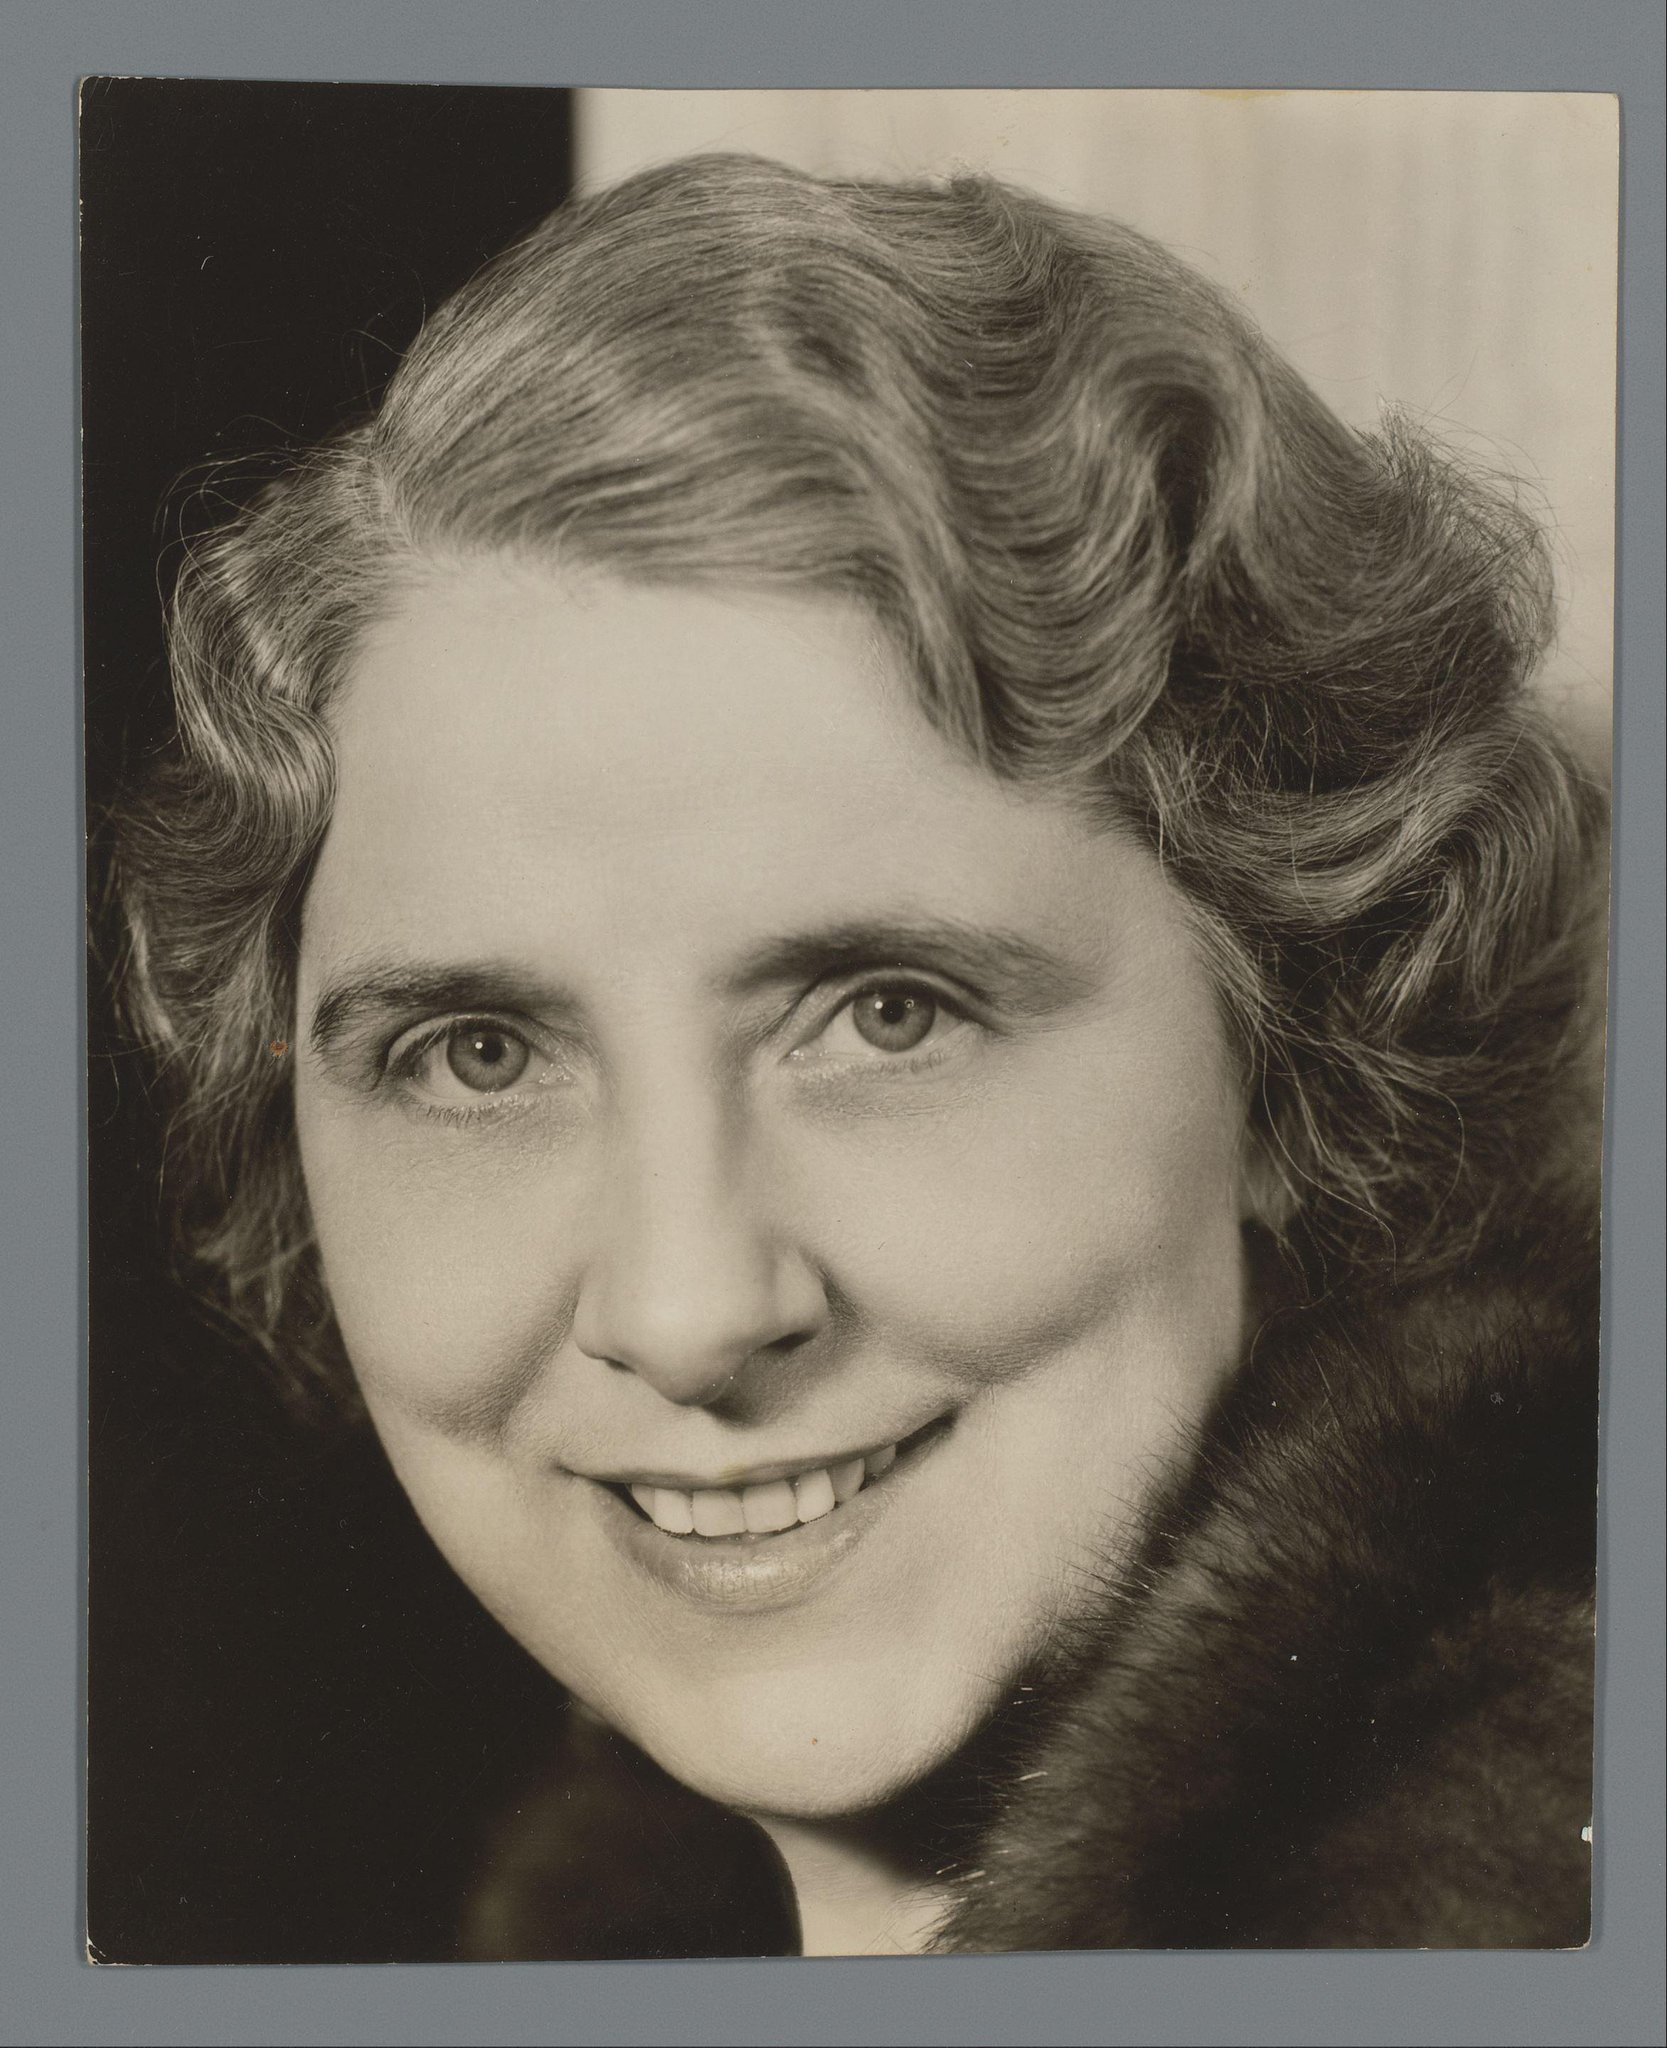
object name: photograph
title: Portret van een onbekende vrouw, mogelijk een actrice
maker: Anonymous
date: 1947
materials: paper, ink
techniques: gelatin silver print, pen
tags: adult woman, anonymous historical person portrayed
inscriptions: inscription: ‘To thank you for/ the excellent pen/ portrait./ Sincerely/ [...]/ 1947’